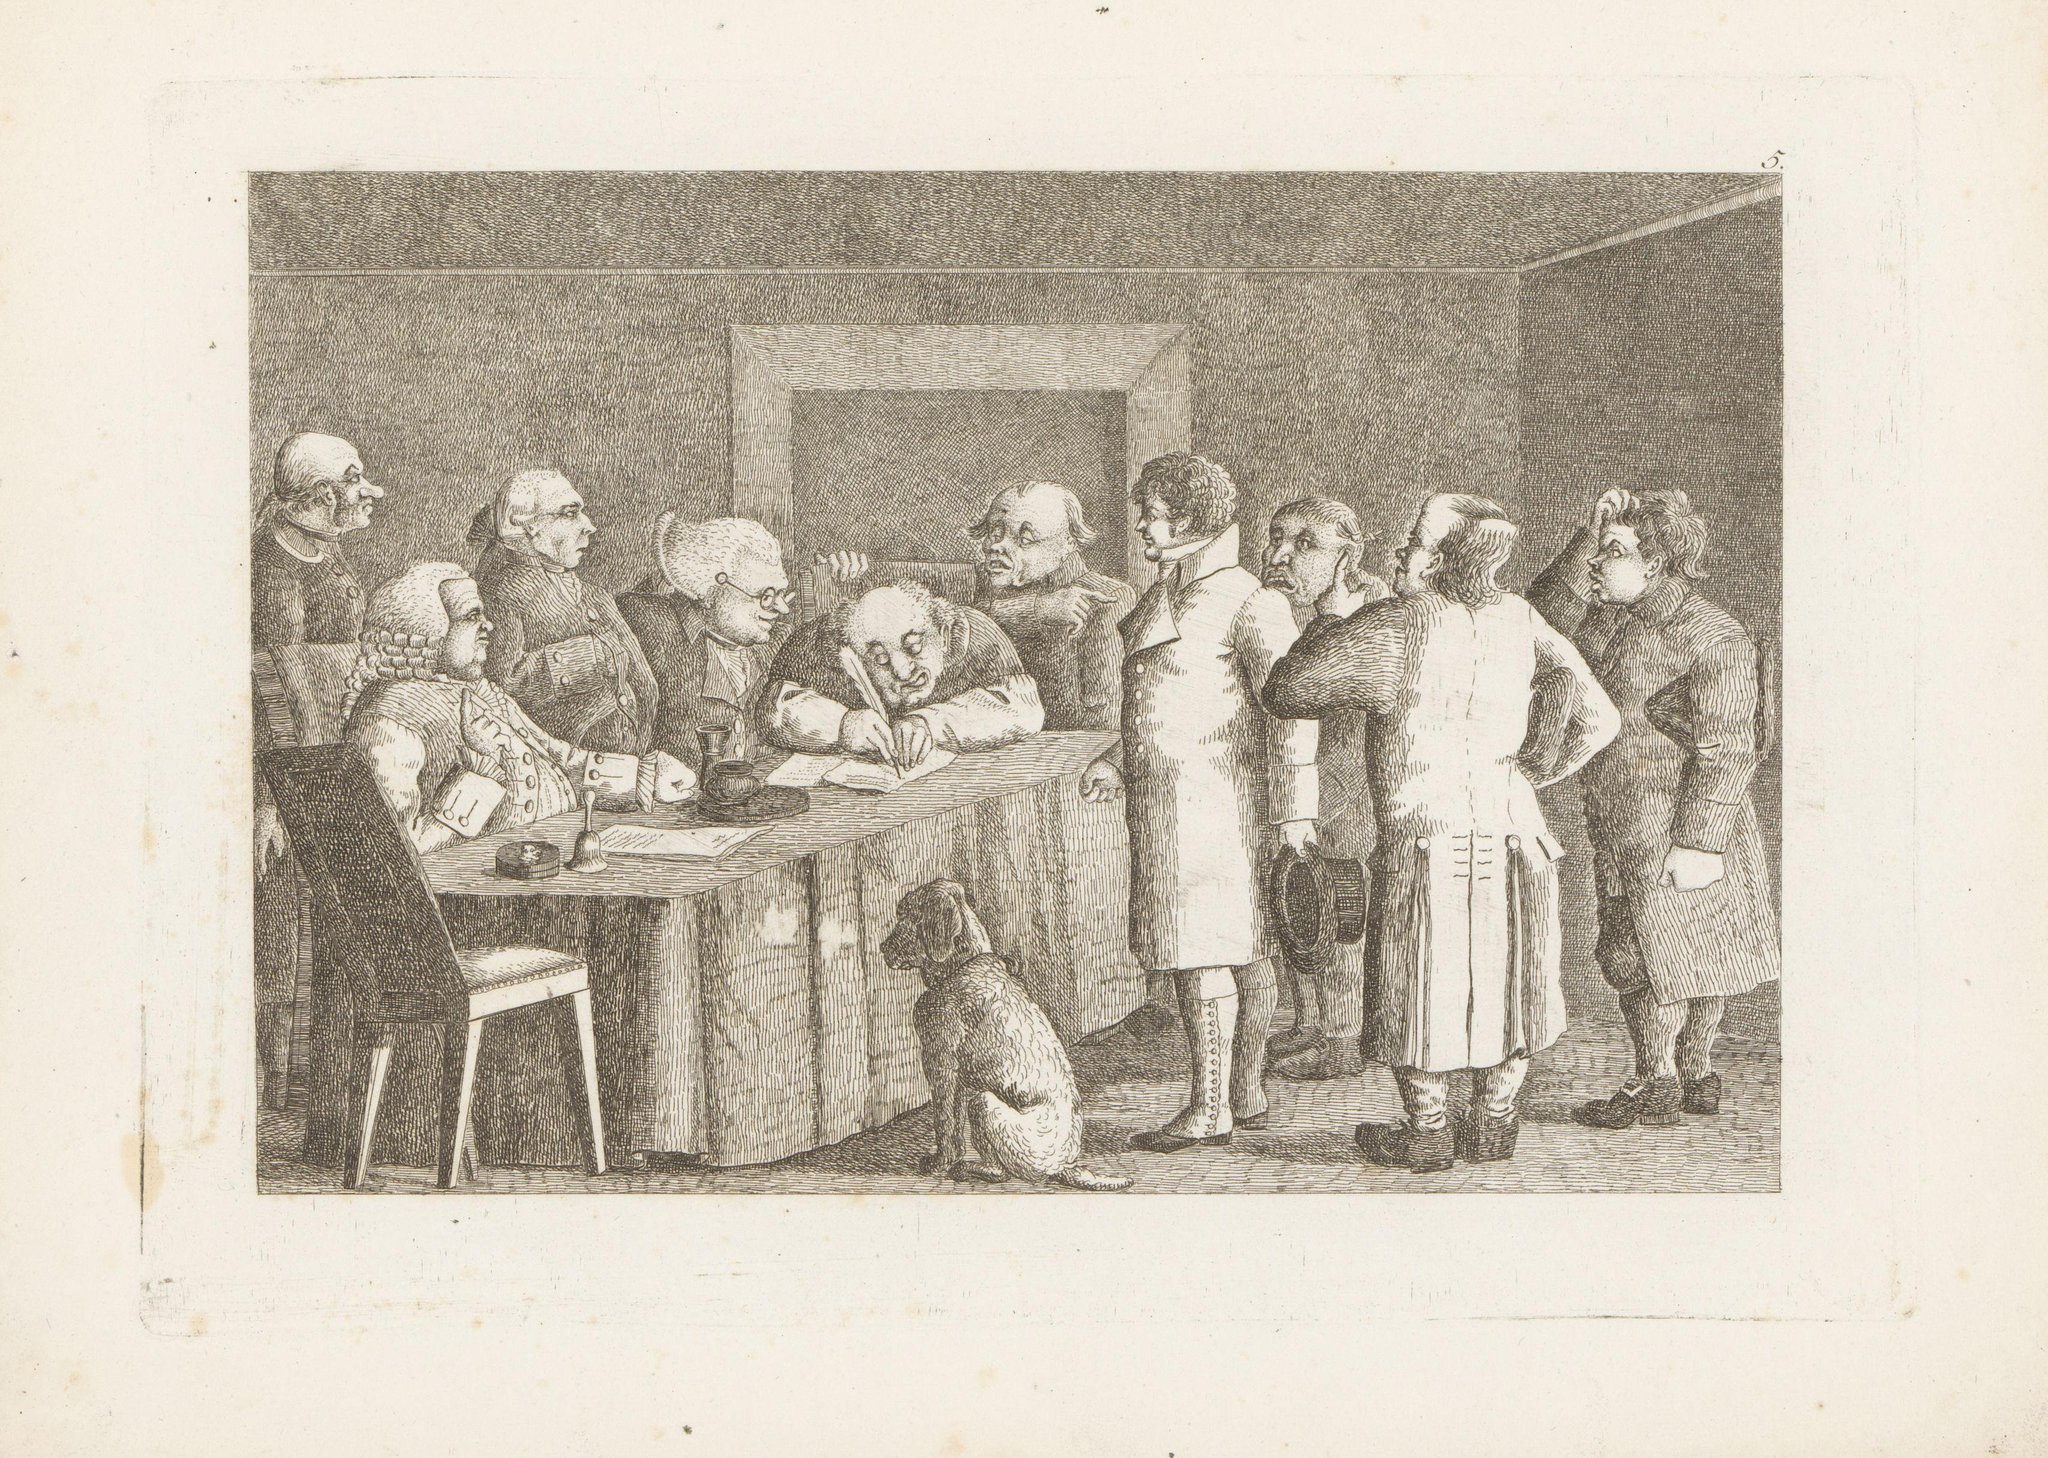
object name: print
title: Die Abentheuer eines reisenden Mahlers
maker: friedrich rottmann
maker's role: print maker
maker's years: 1768-1816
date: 1788-1806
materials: paper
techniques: etching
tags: writing-table, writing-desk, handwriting, writing as activity, old man, painter in non-work situation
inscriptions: collector's mark: Lugt 2228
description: Onderdeel van een serie die bestaat uit: titelblad, 6 etsen en 2 bladen uitleg in boekdruk.